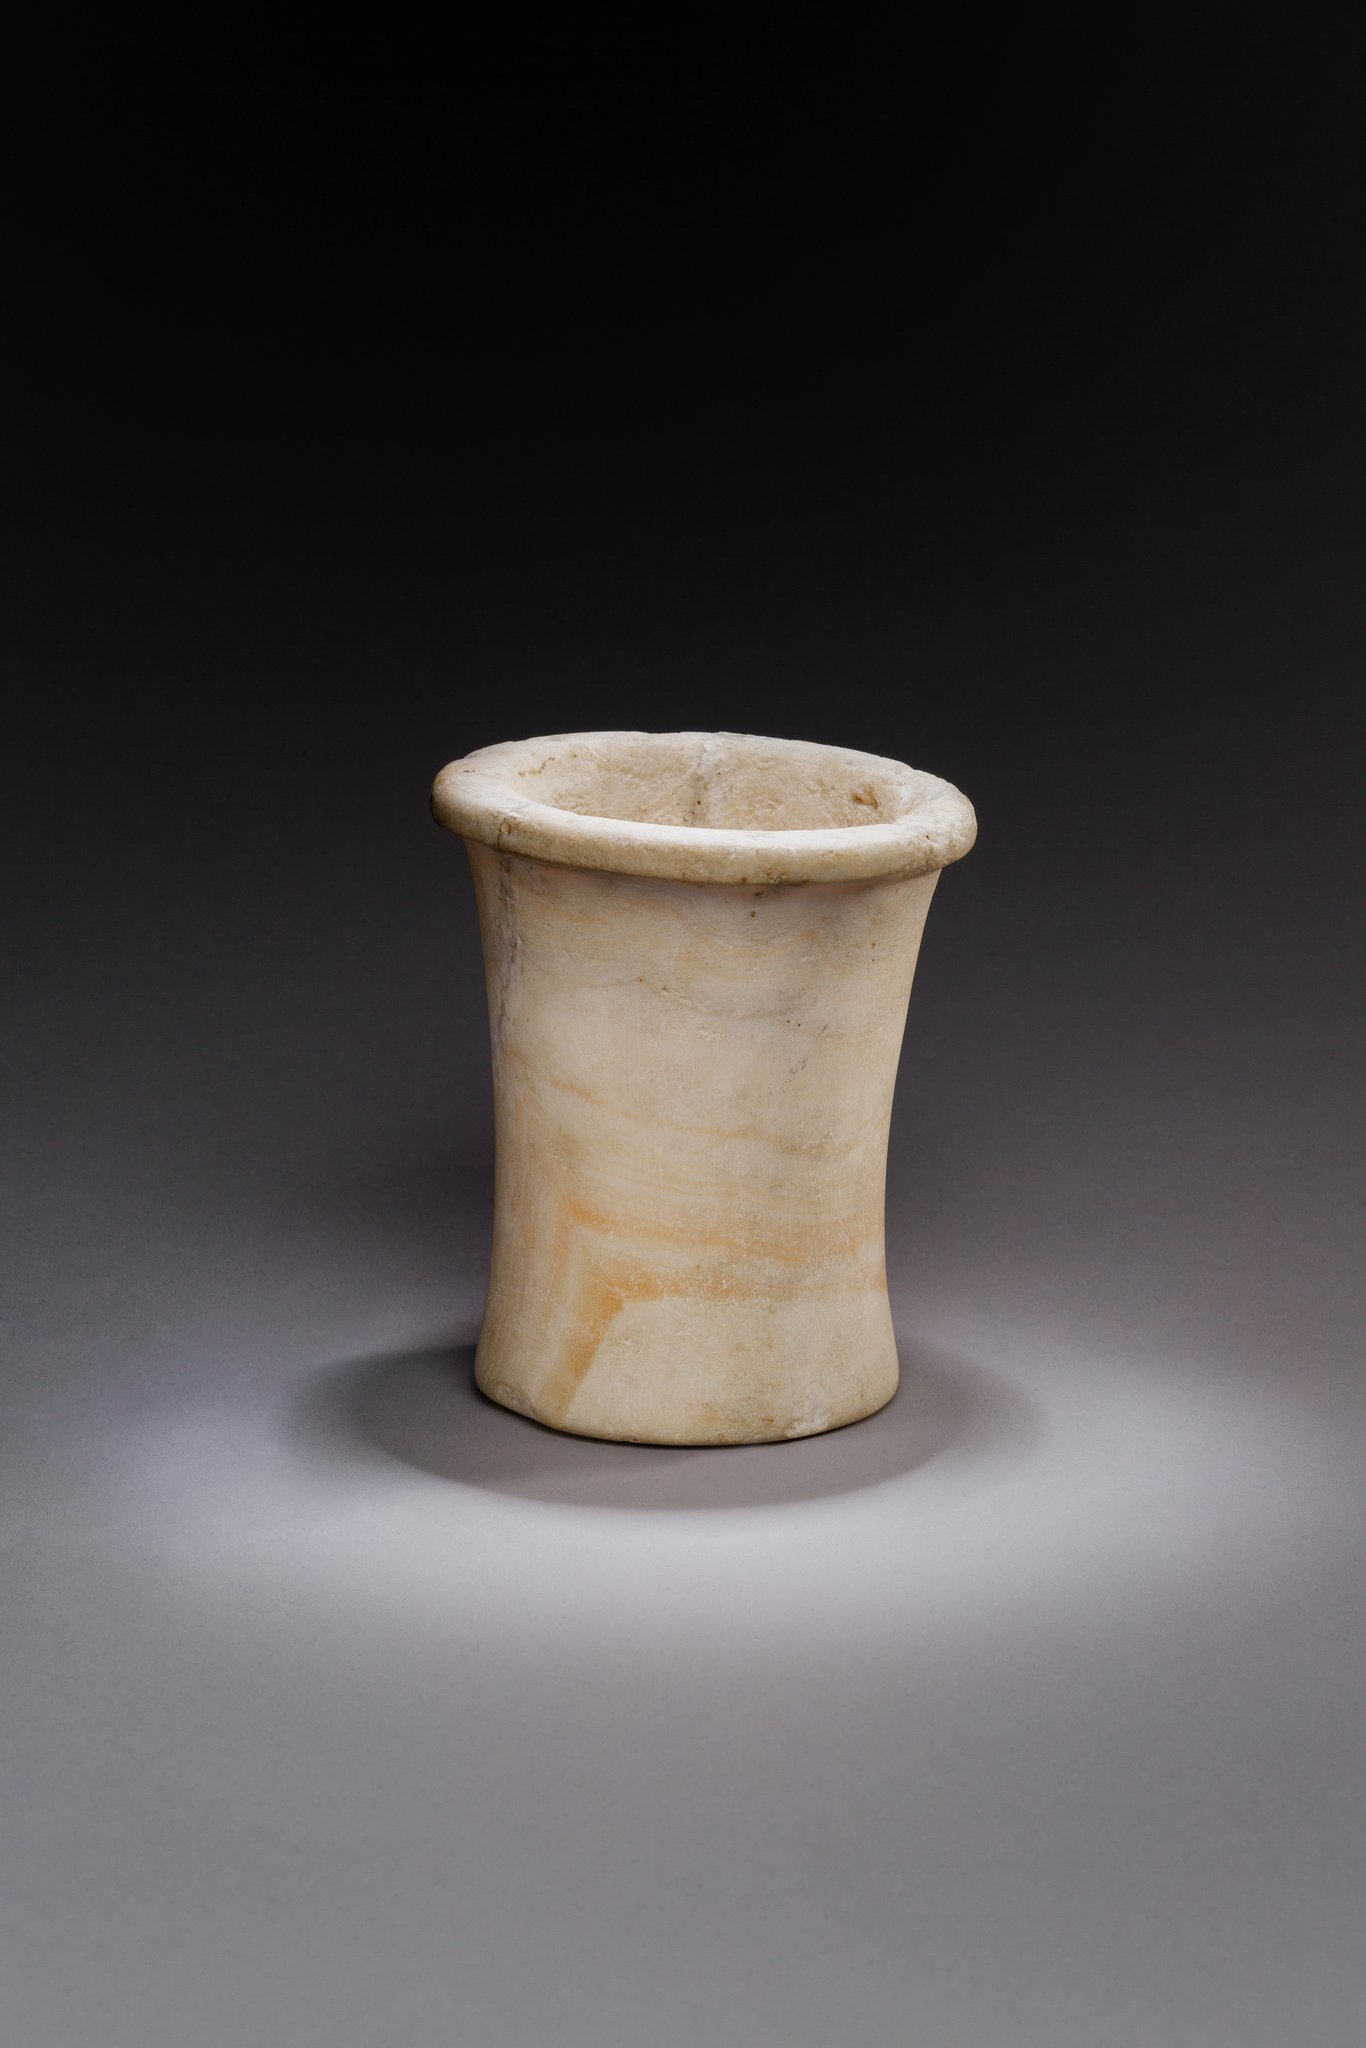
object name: jar, cylindrical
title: Cylindrical jar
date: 2750-2649 BCE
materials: stone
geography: egypt